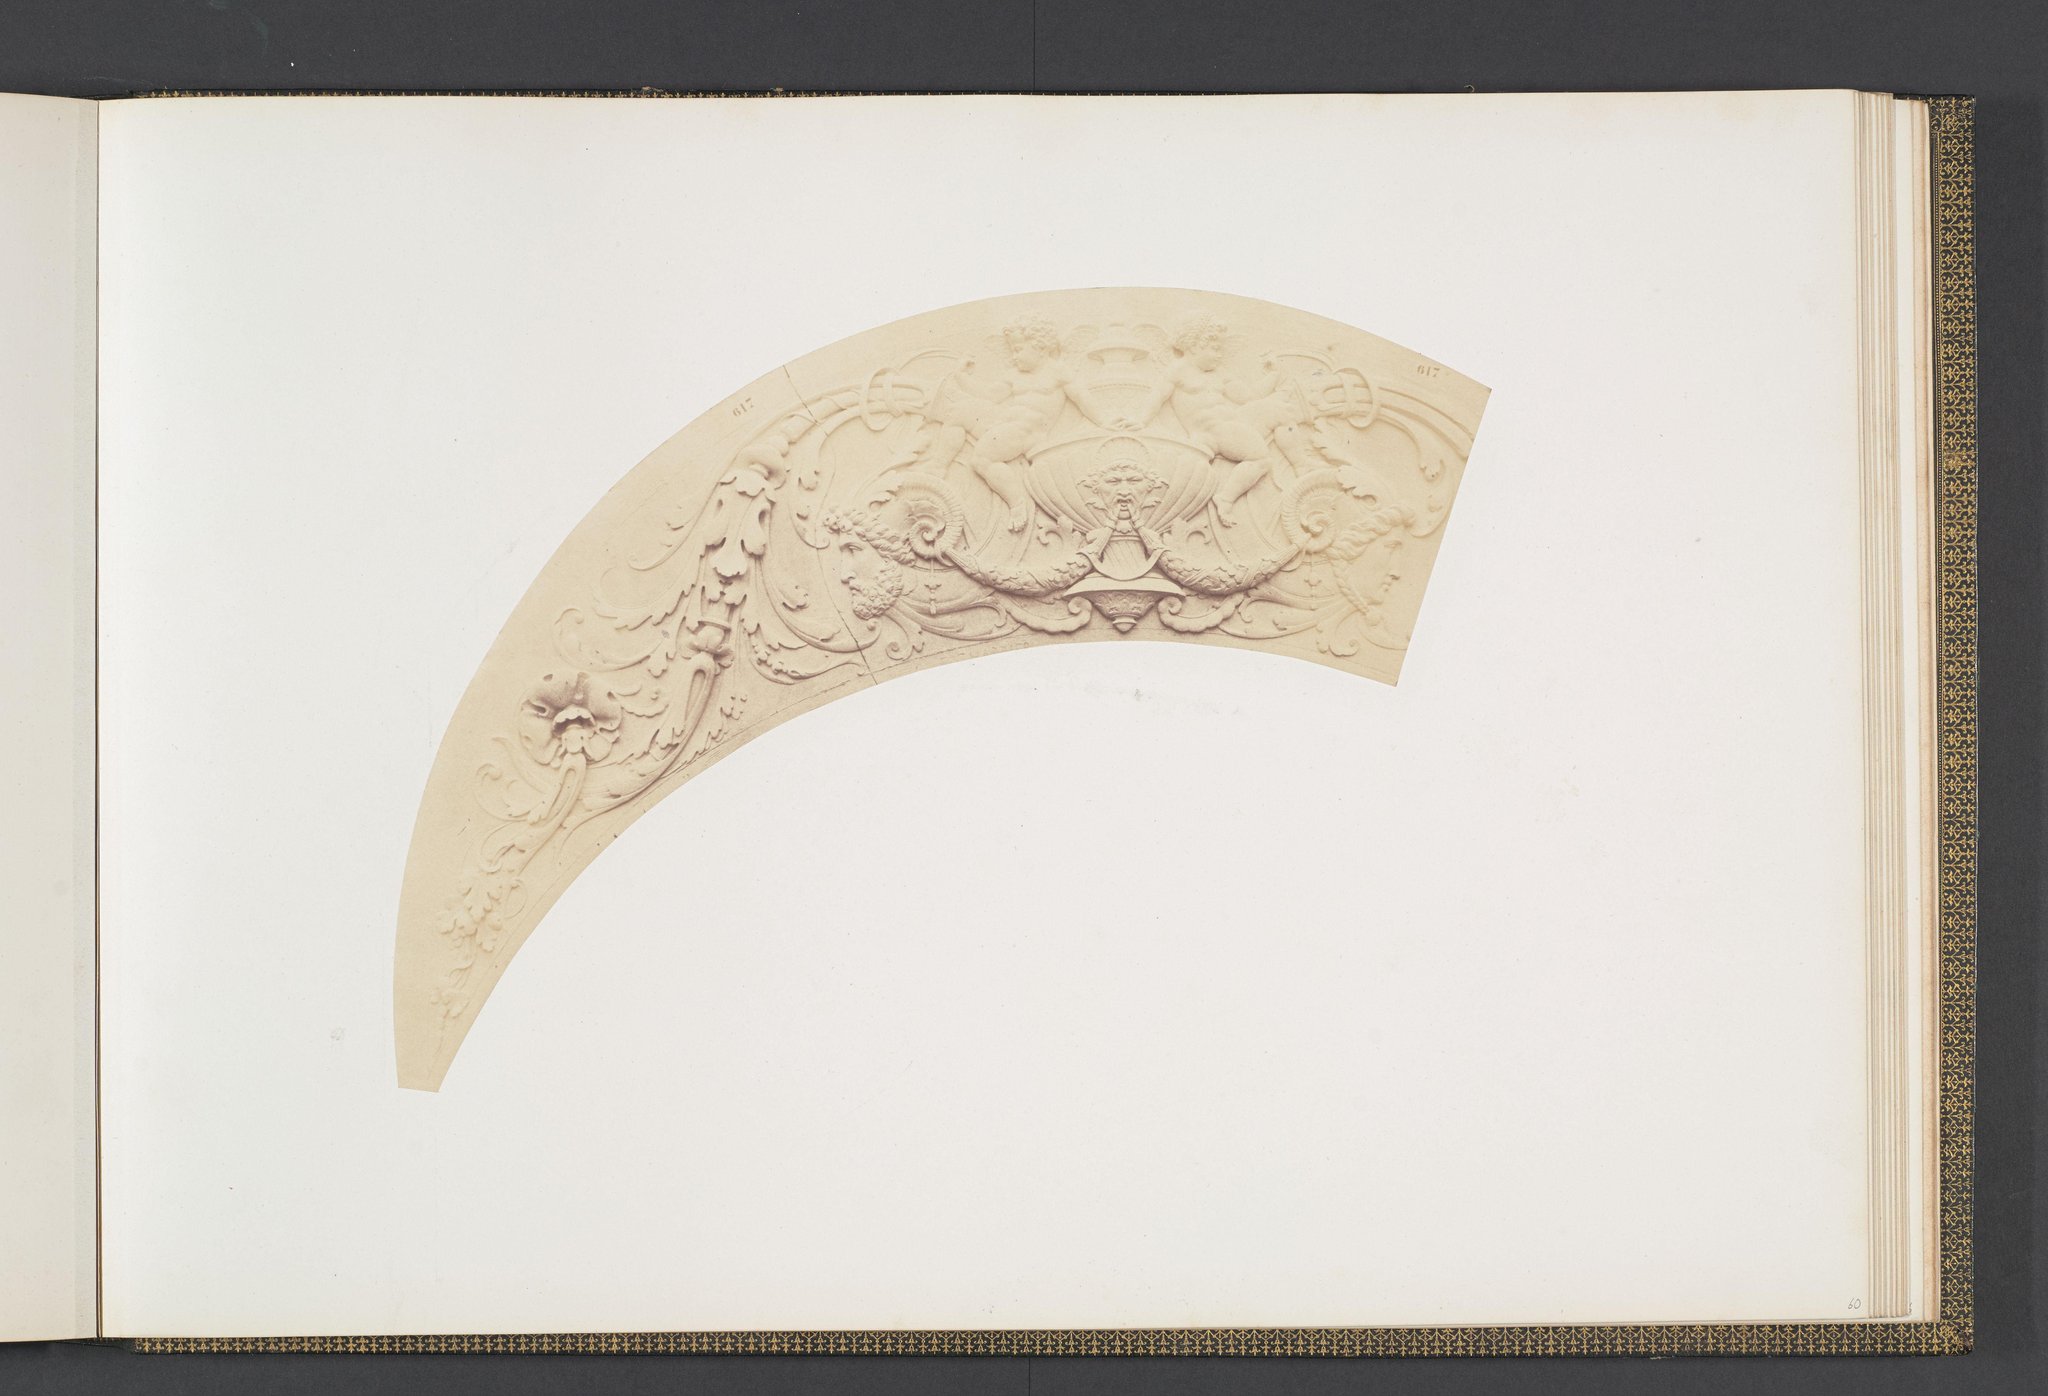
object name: photograph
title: Gipsmodel voor een gewelfversiering van het Palais du Louvre door Pierre Edouard Charrier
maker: édouard denis baldus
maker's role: fotograaf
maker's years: 1813-1889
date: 1855-1857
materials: paper, photographic support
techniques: salted paper print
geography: paris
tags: permanent exhibition, museum, ornamenting, decorating ~ applied arts, paris, tuileries palace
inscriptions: number: ‘617’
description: Onderdeel van Réunion des Tuileries au Louvre 1852-1857, album 3.